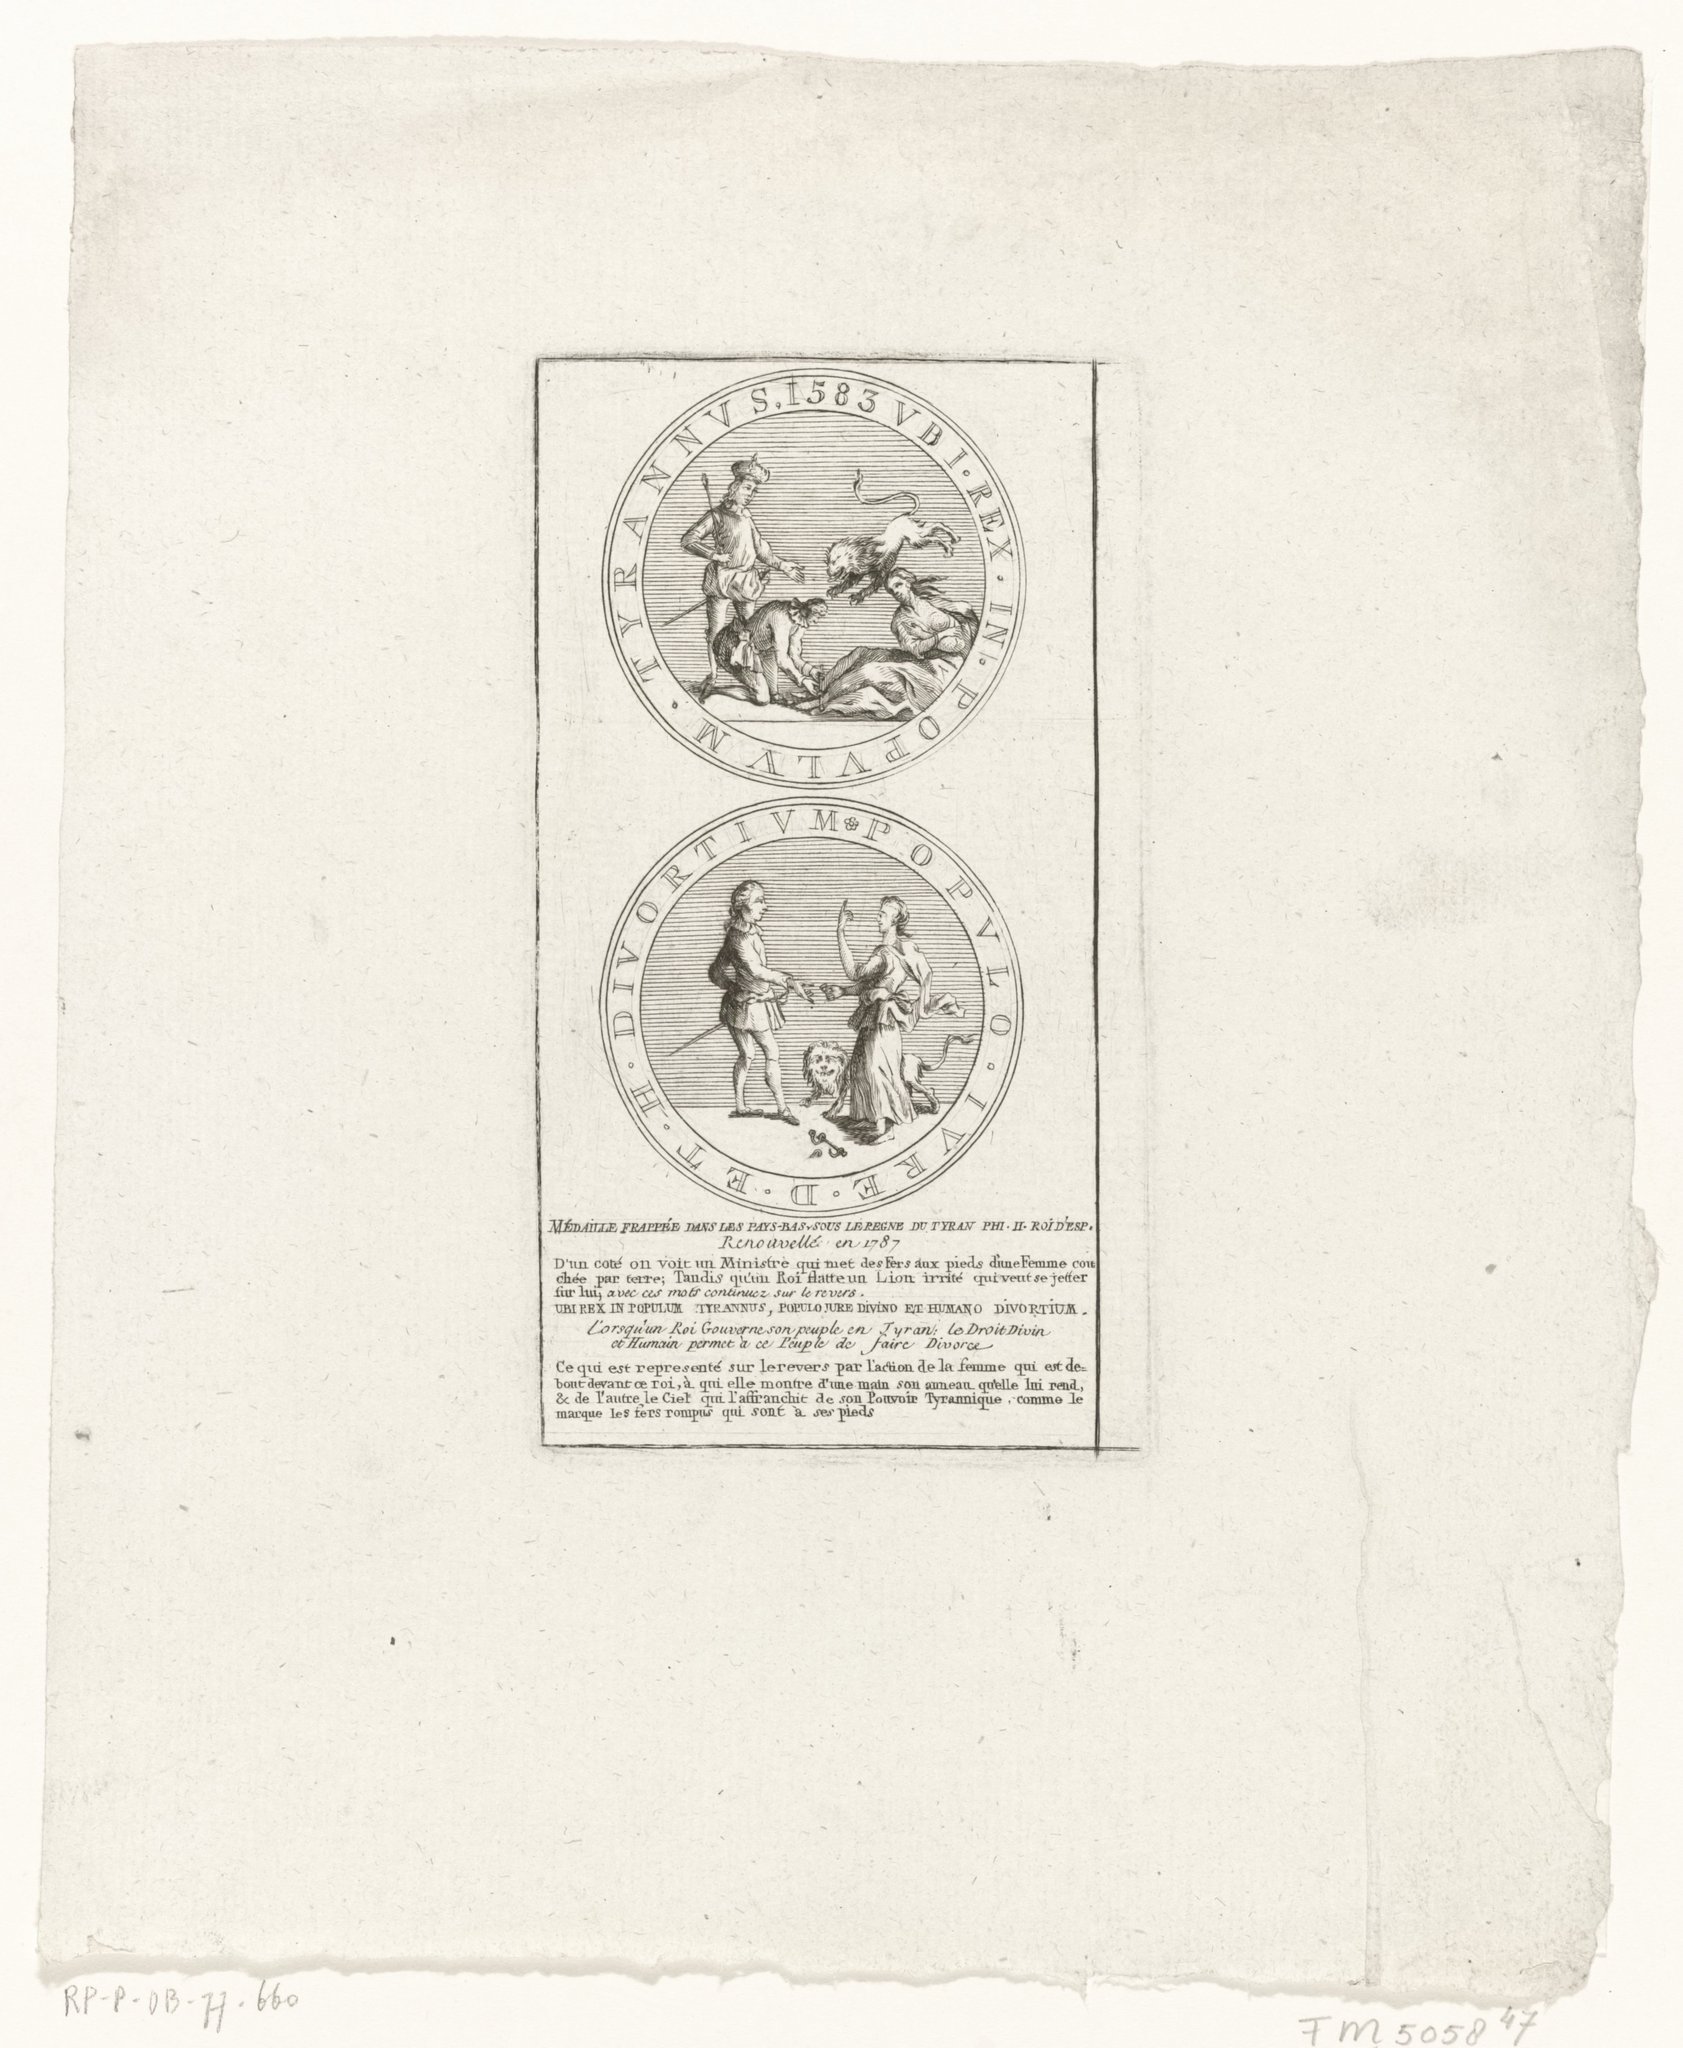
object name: print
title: Penning tegen Jozef II, 1787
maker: Anonymous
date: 1787-1790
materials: paper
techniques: engraving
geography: southern netherlands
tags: philip ii of spain, vienna, jozef ii (duits keizer), medal (considered as a piece of sculpture, regardless of its specific function), brabant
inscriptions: collector's mark: Lugt 2228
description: Beide zijden van een penning oorspronkelijk tegen de tiran Filips II geslagen in 1583 tijdens de Nederlandse Opstand en heruitgegeven tegen de Oostenrijkse keizer Jozef II in 1787. Met uitleg in het Frans. Onderdeel van een grote groep van prenten betrekking hebbend op de gebeurtenissen van de Brabantse Omwenteling en de periode 1787-1790.